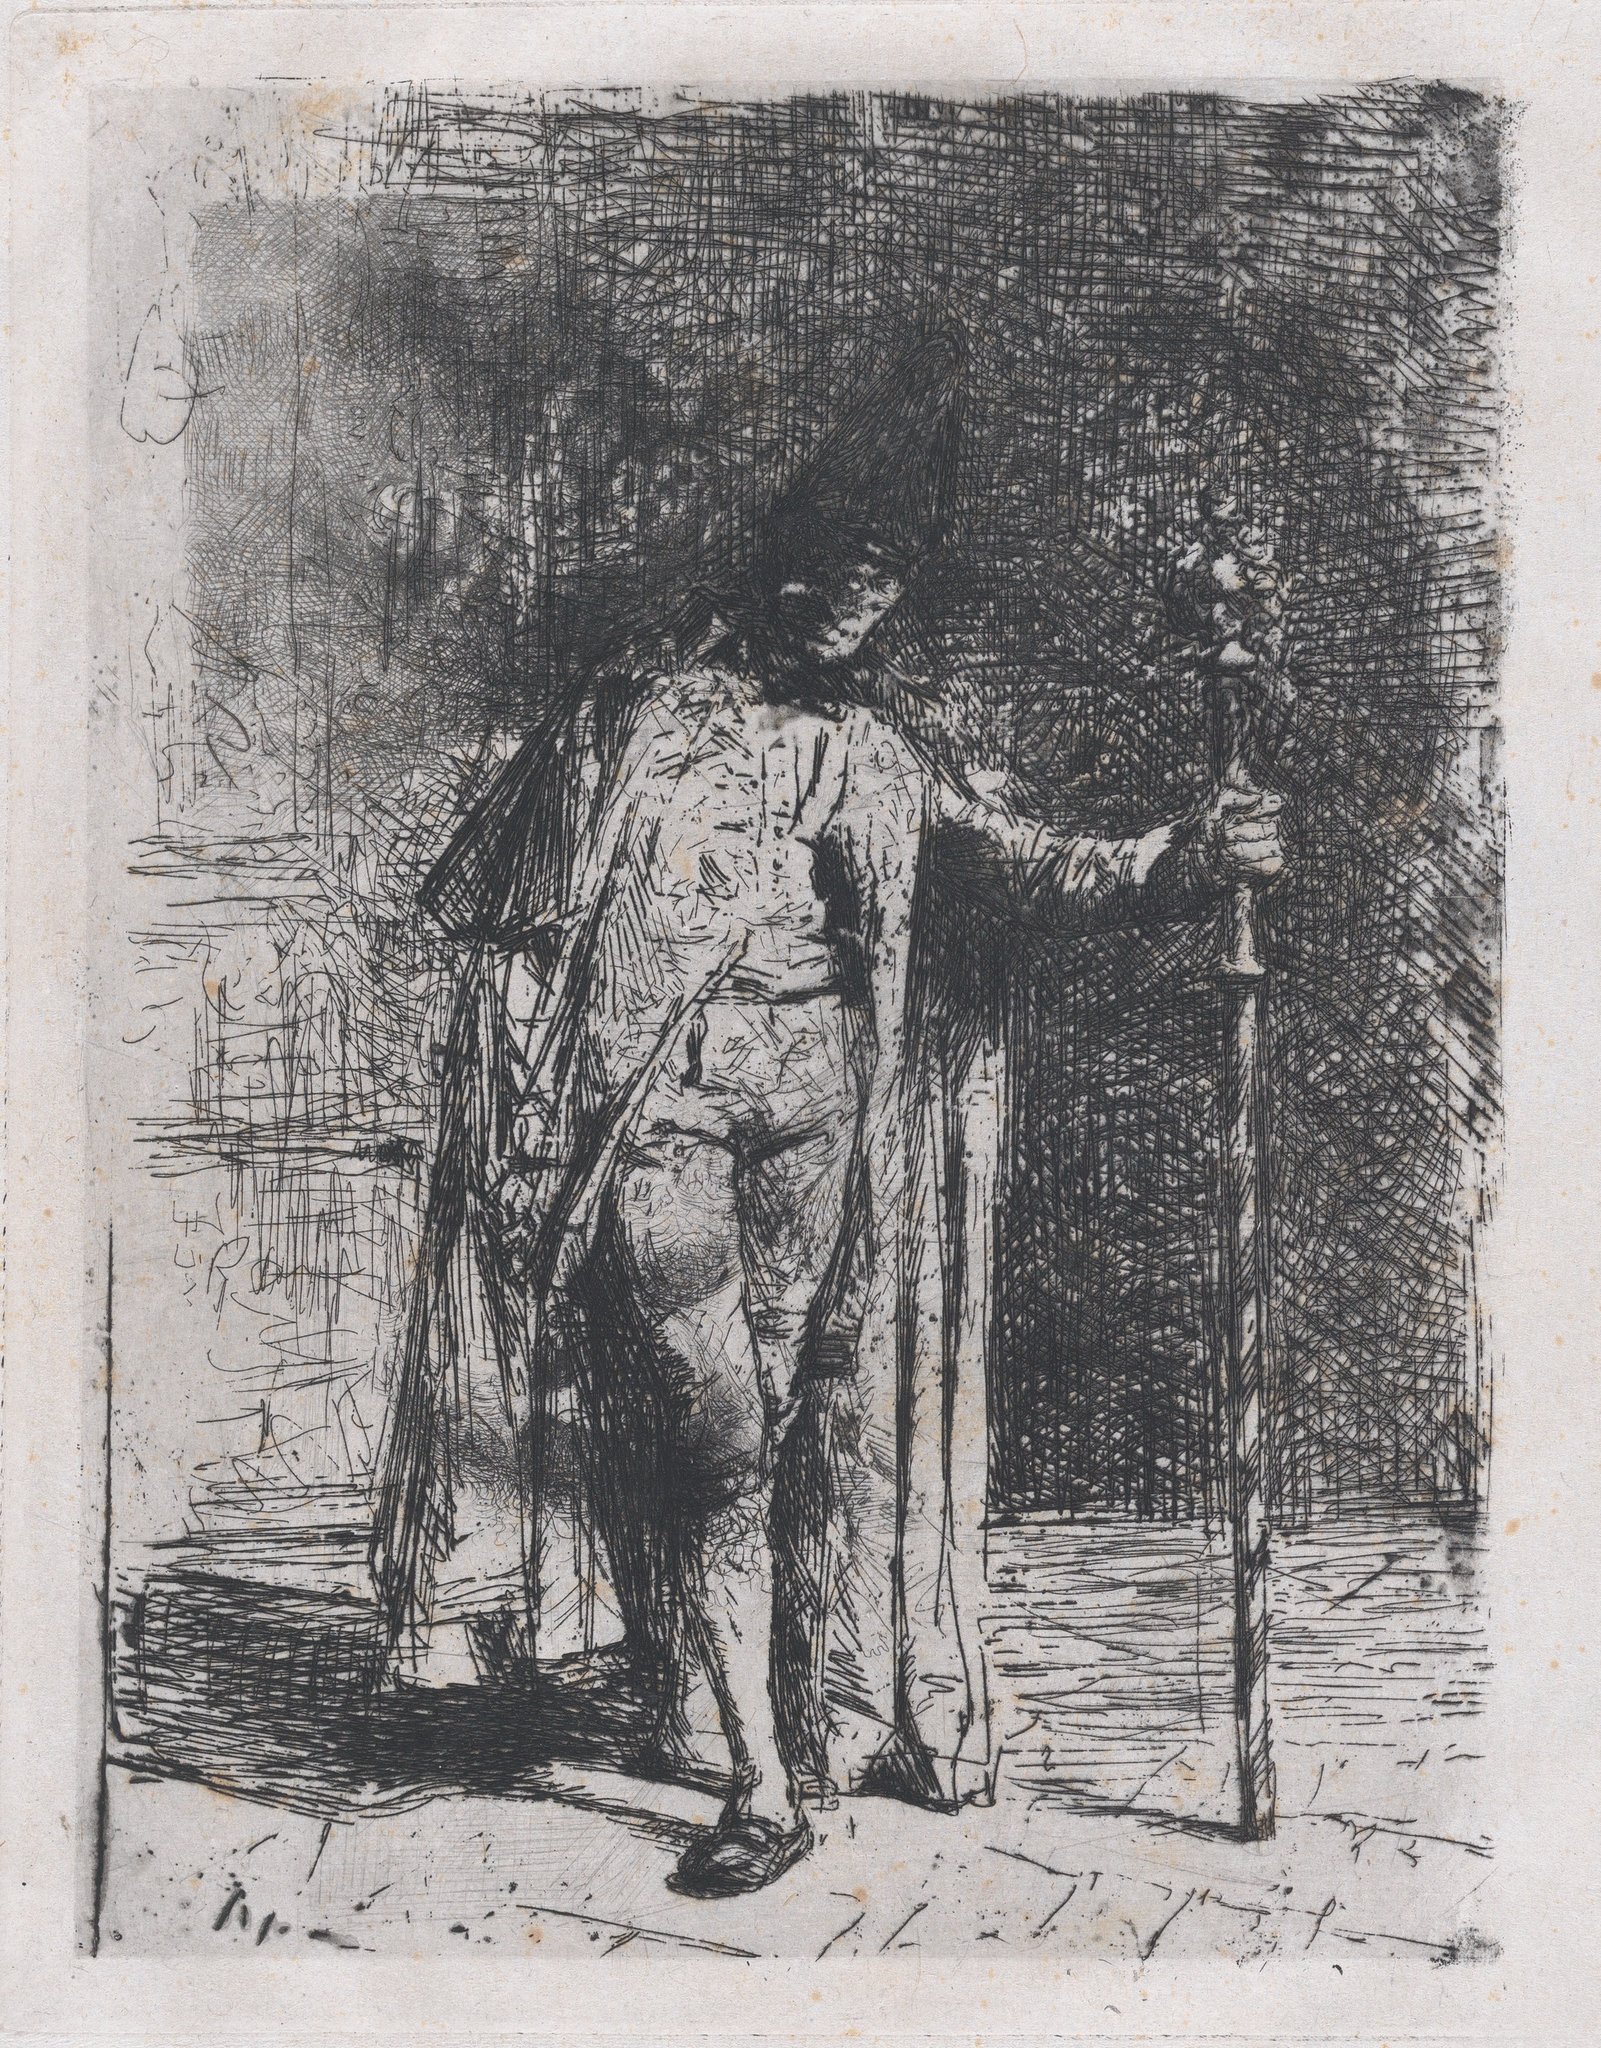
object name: print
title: Master of ceremonies, a man standing facing the viewer holding a staff in his left hand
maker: mariano fortuny, 1838–1874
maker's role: artist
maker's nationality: spanish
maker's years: 1838-1874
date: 1865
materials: paper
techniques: etching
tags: men